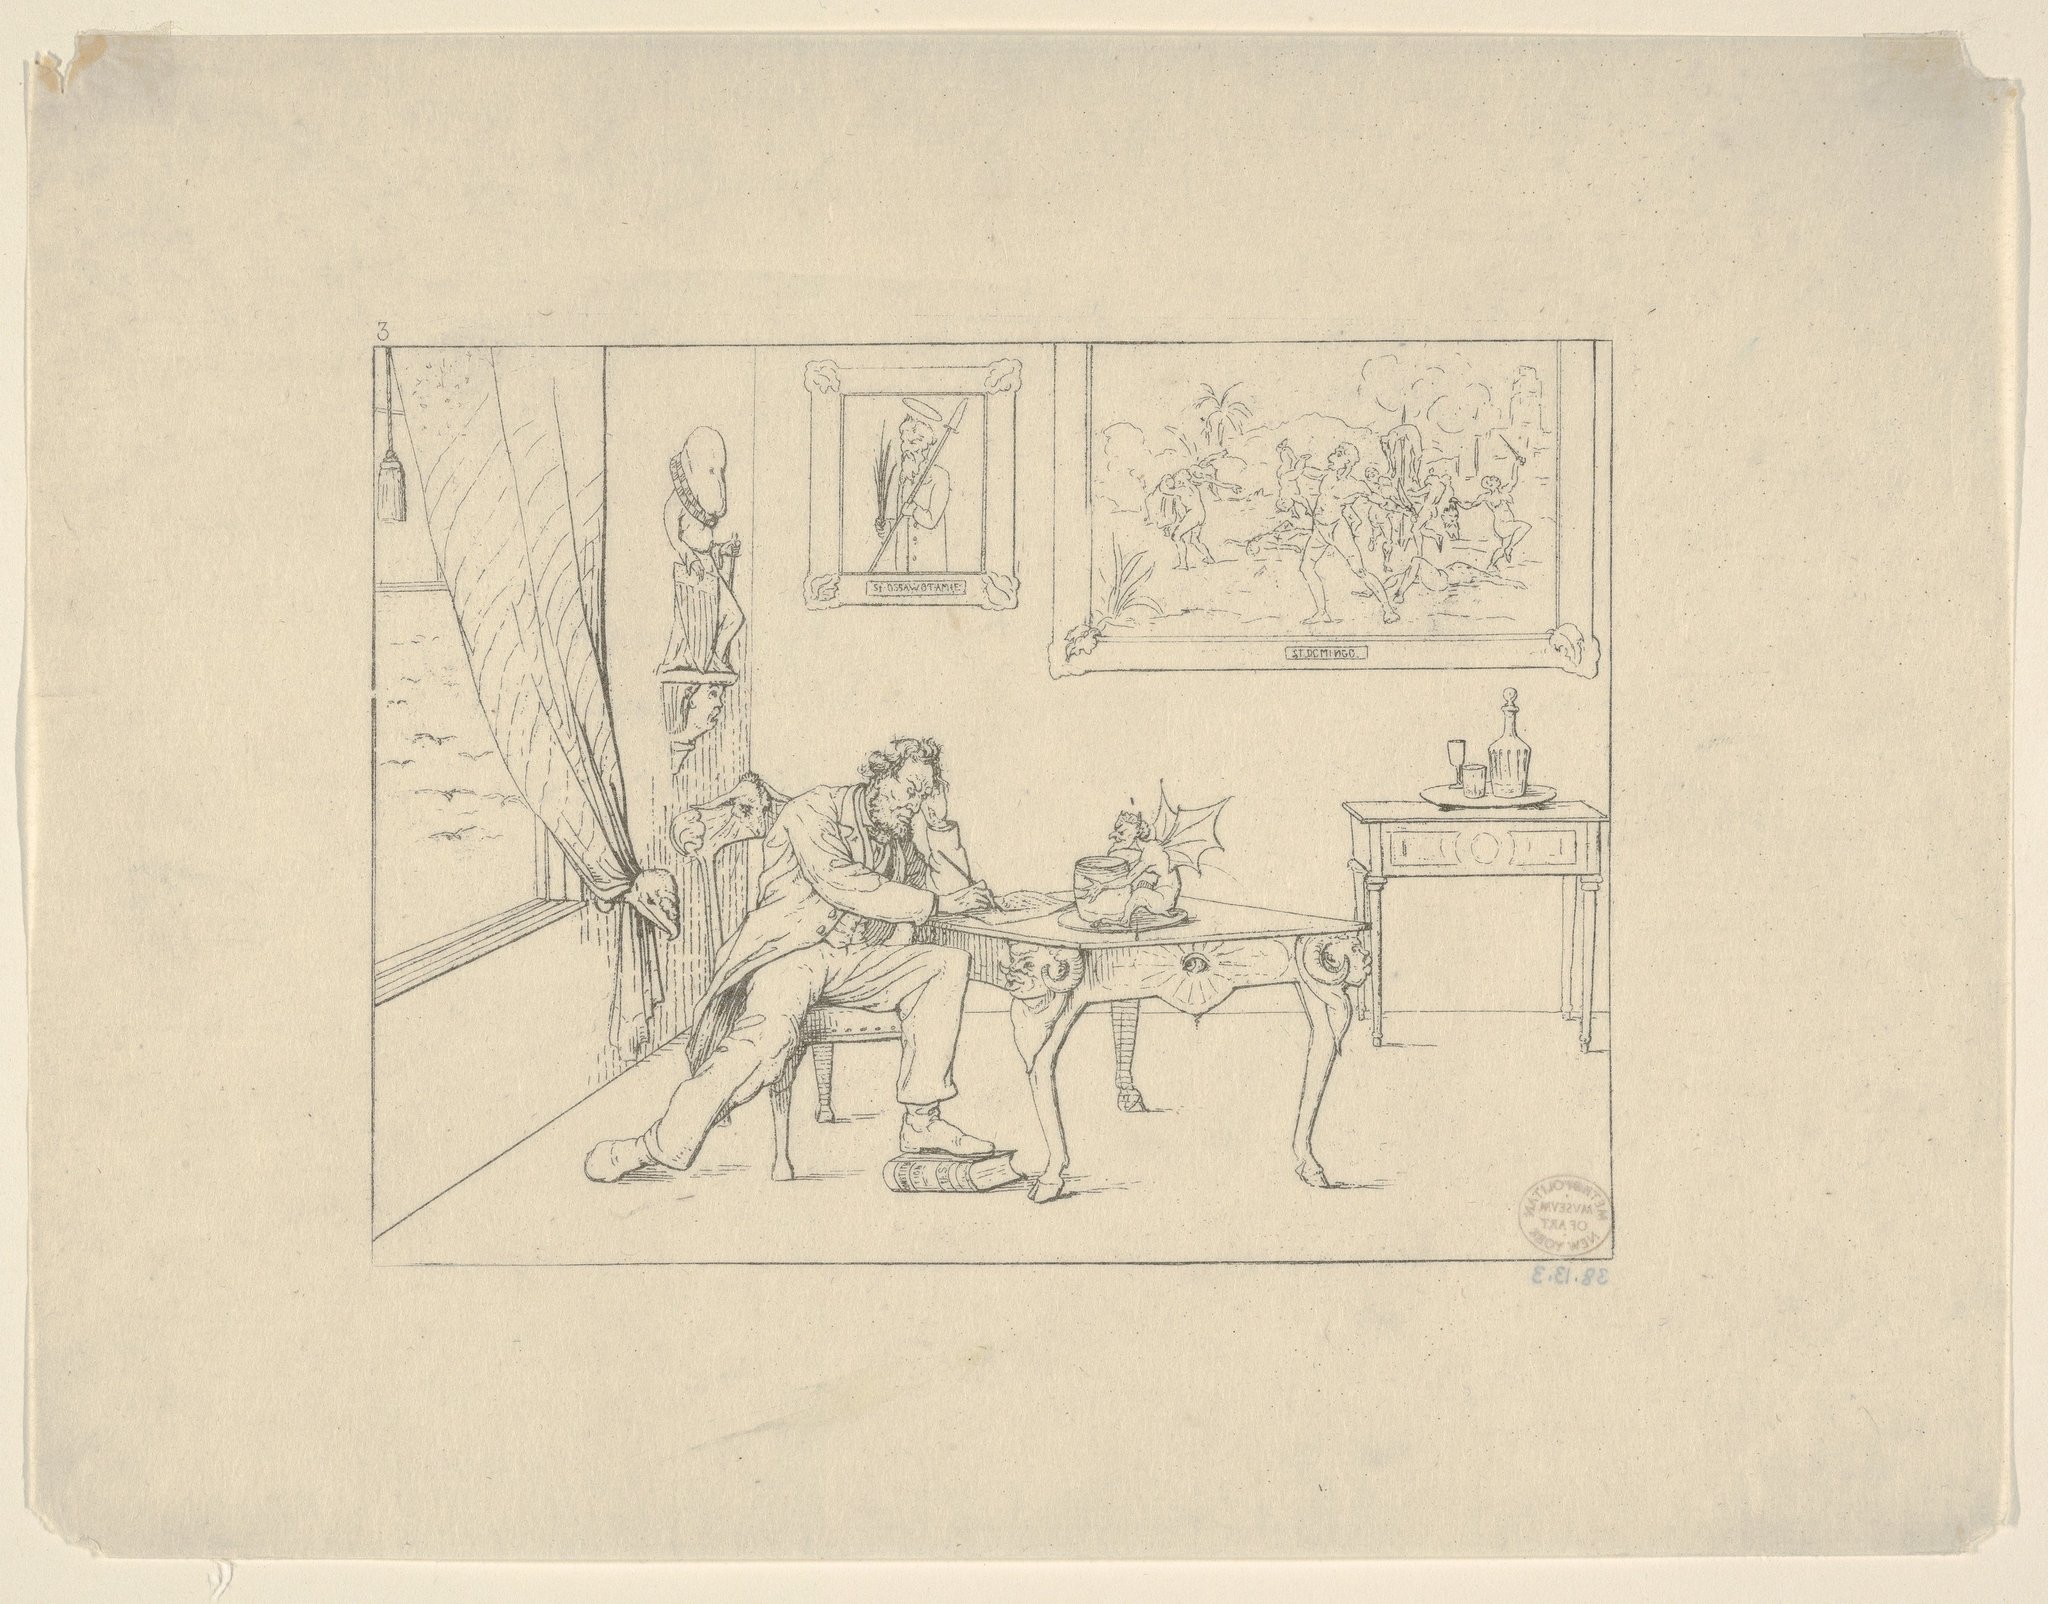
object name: print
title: Writing the Emancipation Proclamation (from Confederate War Etchings)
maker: adalbert john volck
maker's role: artist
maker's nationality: american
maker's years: 1828-1912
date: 1861-1863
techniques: etching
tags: american civil war,abraham lincoln,men,writing,desks